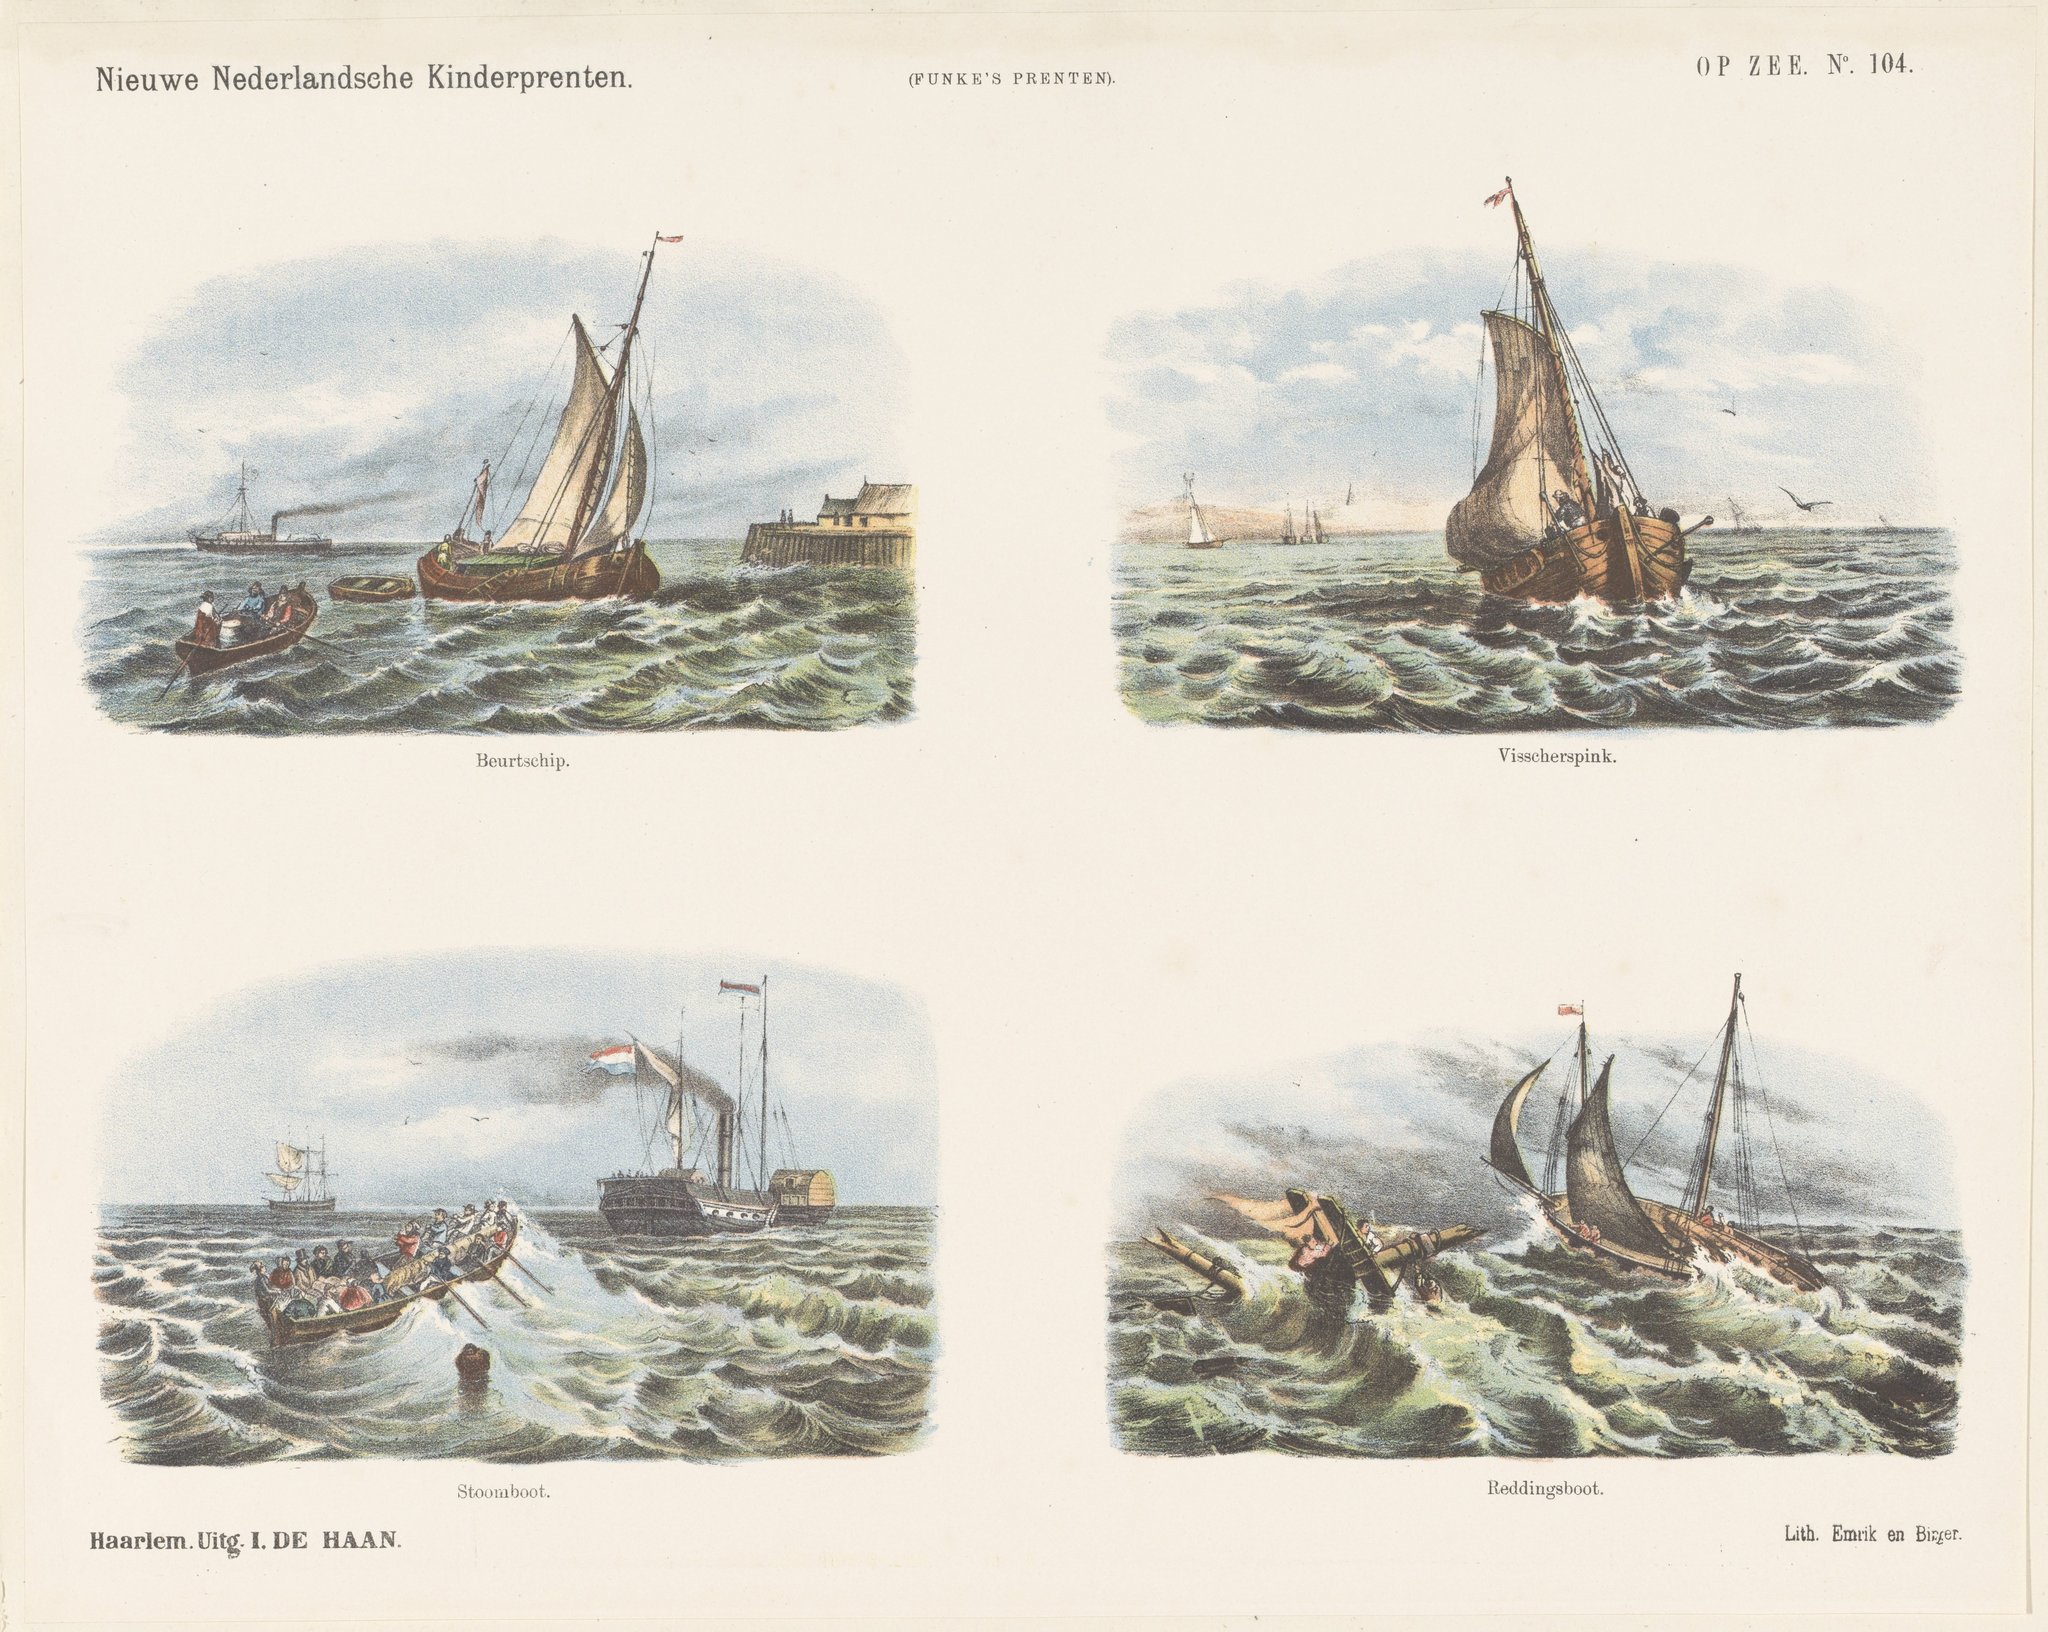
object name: print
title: Funke's prenten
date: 1875-1903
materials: paper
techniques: lithograph, letterpress printing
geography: haarlem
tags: ships (in general)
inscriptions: collector's mark: Lugt 2760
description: Blad met 4 voorstellingen van een beurtschip, een stoomboot, een pink (schip) en een reddingsboot. Onder elke afbeelding een onderschrift. Genummerd rechtsboven: No. 104.